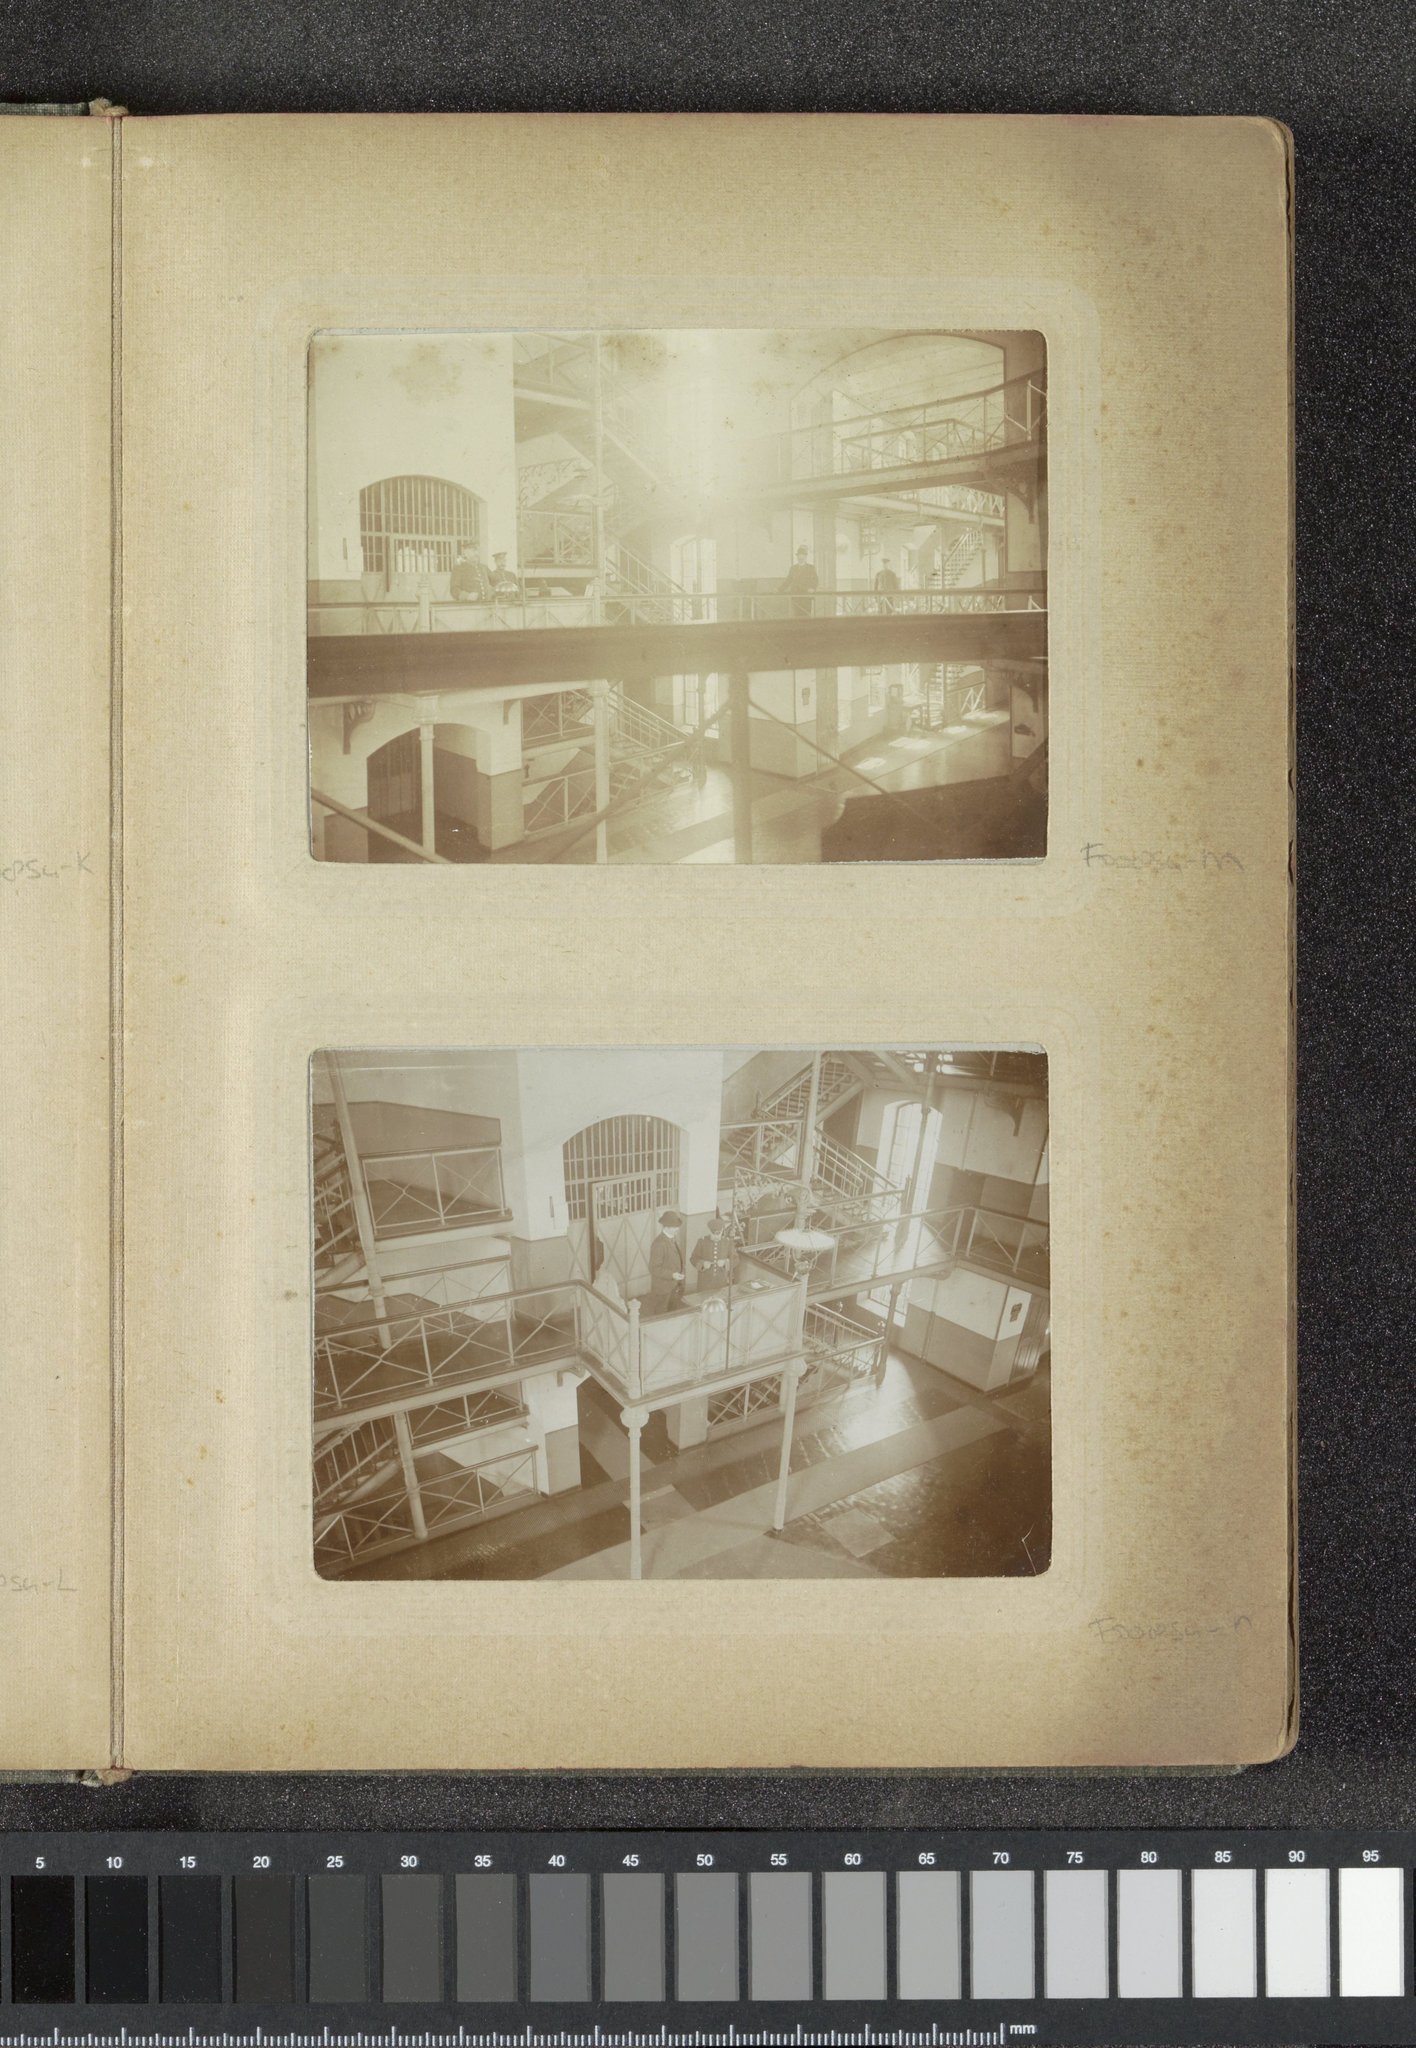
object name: photograph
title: Interieur van de gevangenis van Oslebshausen met gevangenbewaarders op een loopbrug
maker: Anonymous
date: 1890-1910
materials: cardboard, paper, photographic support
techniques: collodion silver print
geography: oslebshausen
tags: prison, jail, prison personnel: jailers, warders, guards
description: Onderdeel van Fotoalbum van Carl Heinrich Fliegenschmidt, gevangenisdirecteur te Oslebshausen.